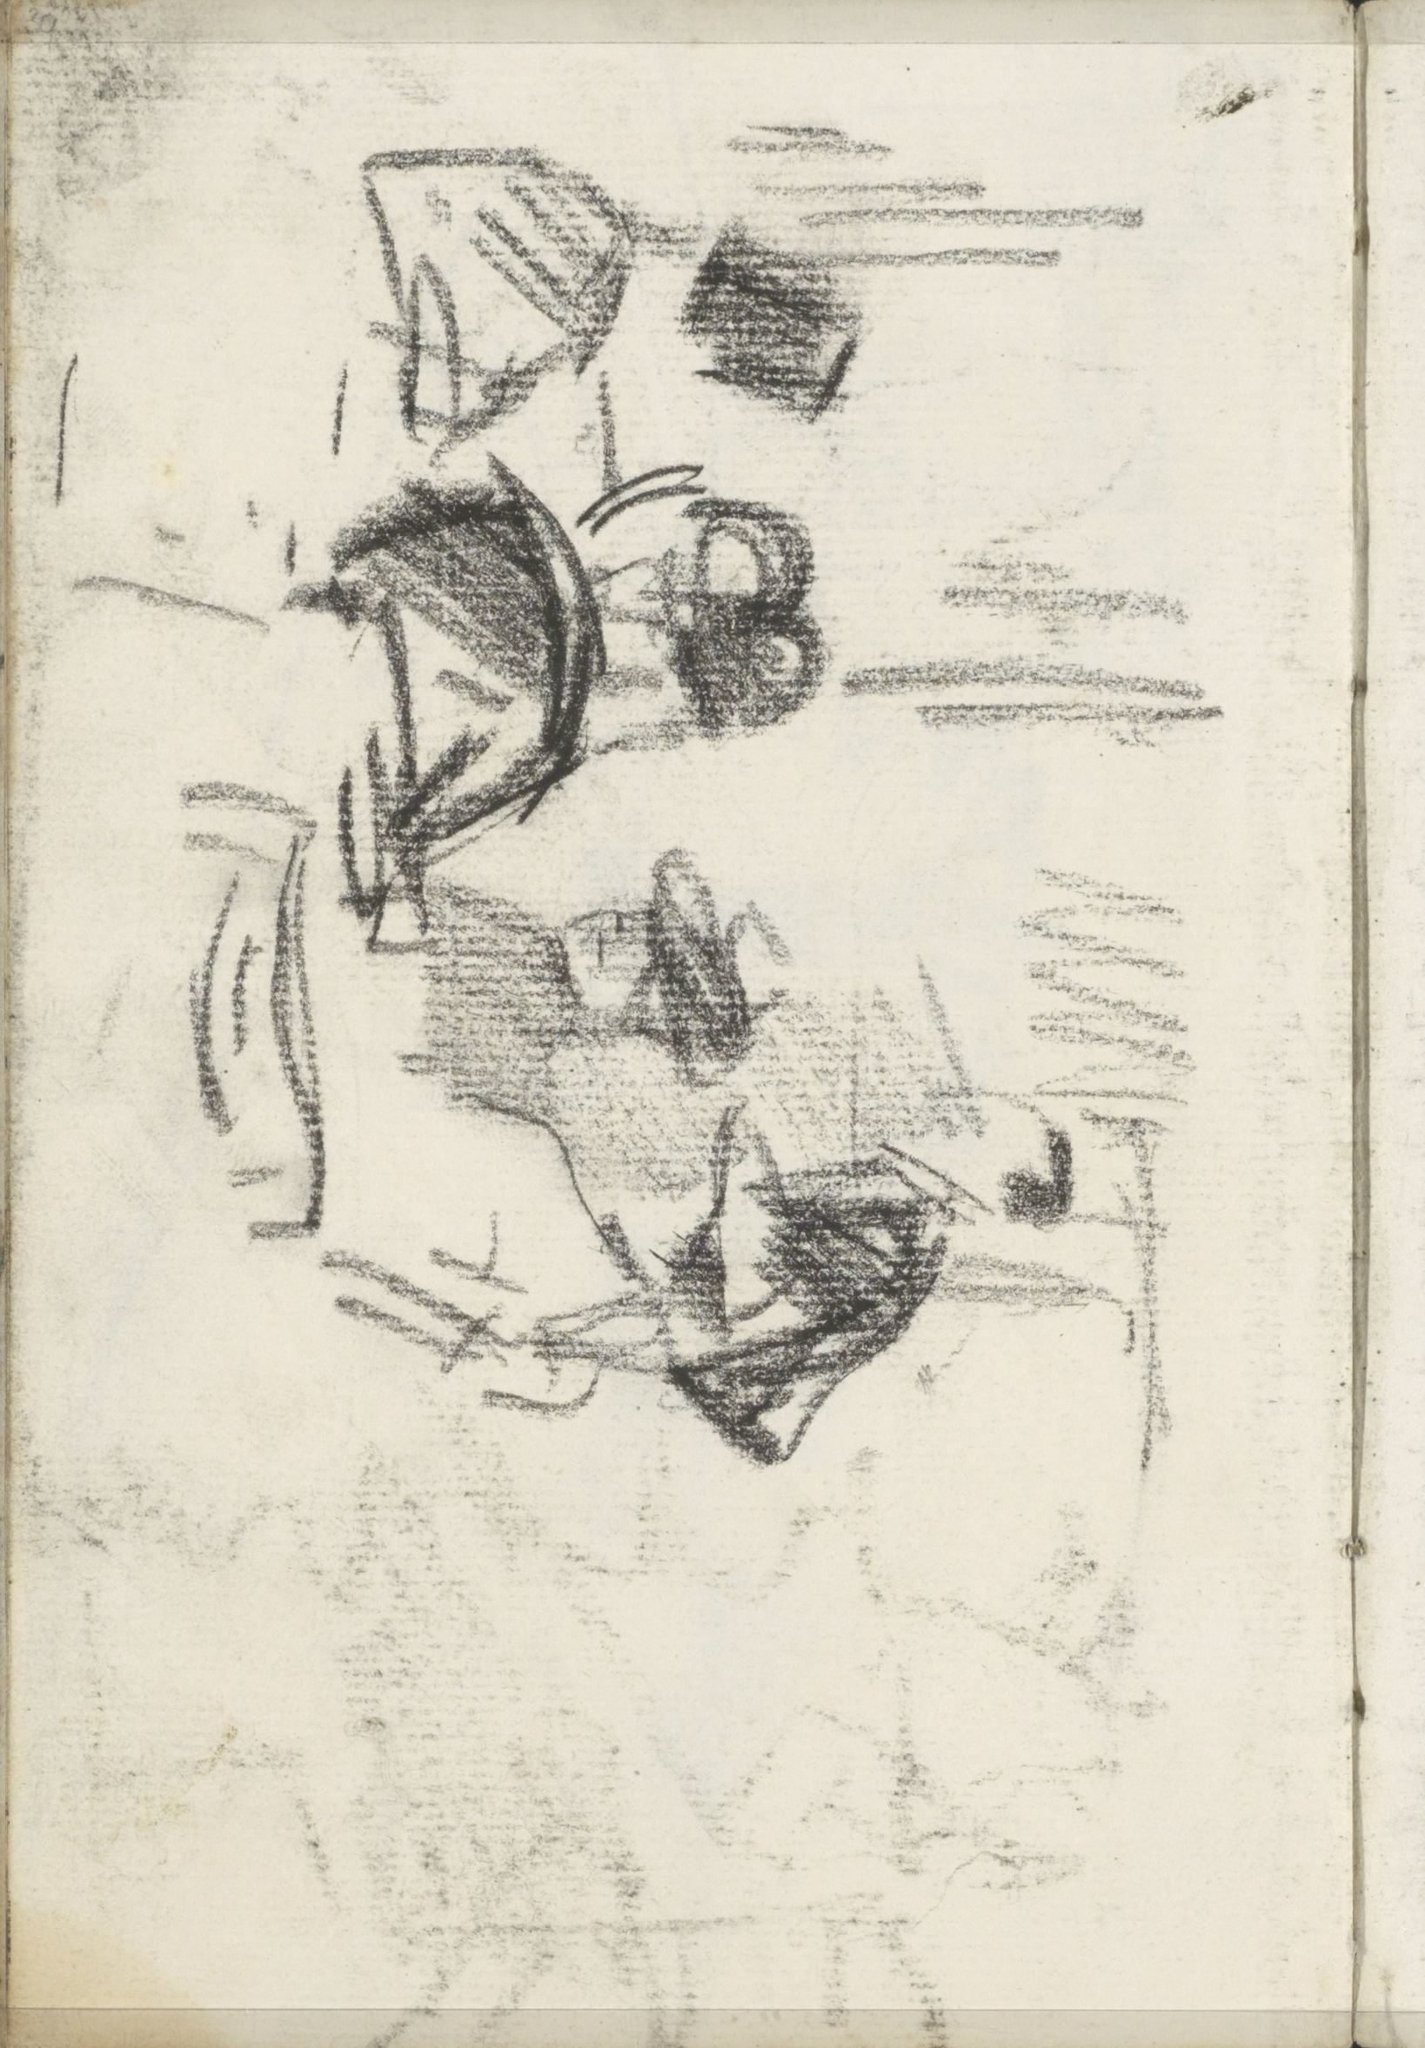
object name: sketchbook leaf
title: Figuren aan een tafel, mogelijk in een etablissement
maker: george hendrik breitner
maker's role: draughtsman, painter, print maker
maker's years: 1857-1923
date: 1895-1898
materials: chalk, paper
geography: amsterdam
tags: sitting figure, sitting figure - aa - female human figure, inn, coffee-house, public house, etc. (+ waiter, waitress, etc.)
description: Bij hen staat mogelijk een ober. Pagina 39 uit een schetsboek met 21 bladen.